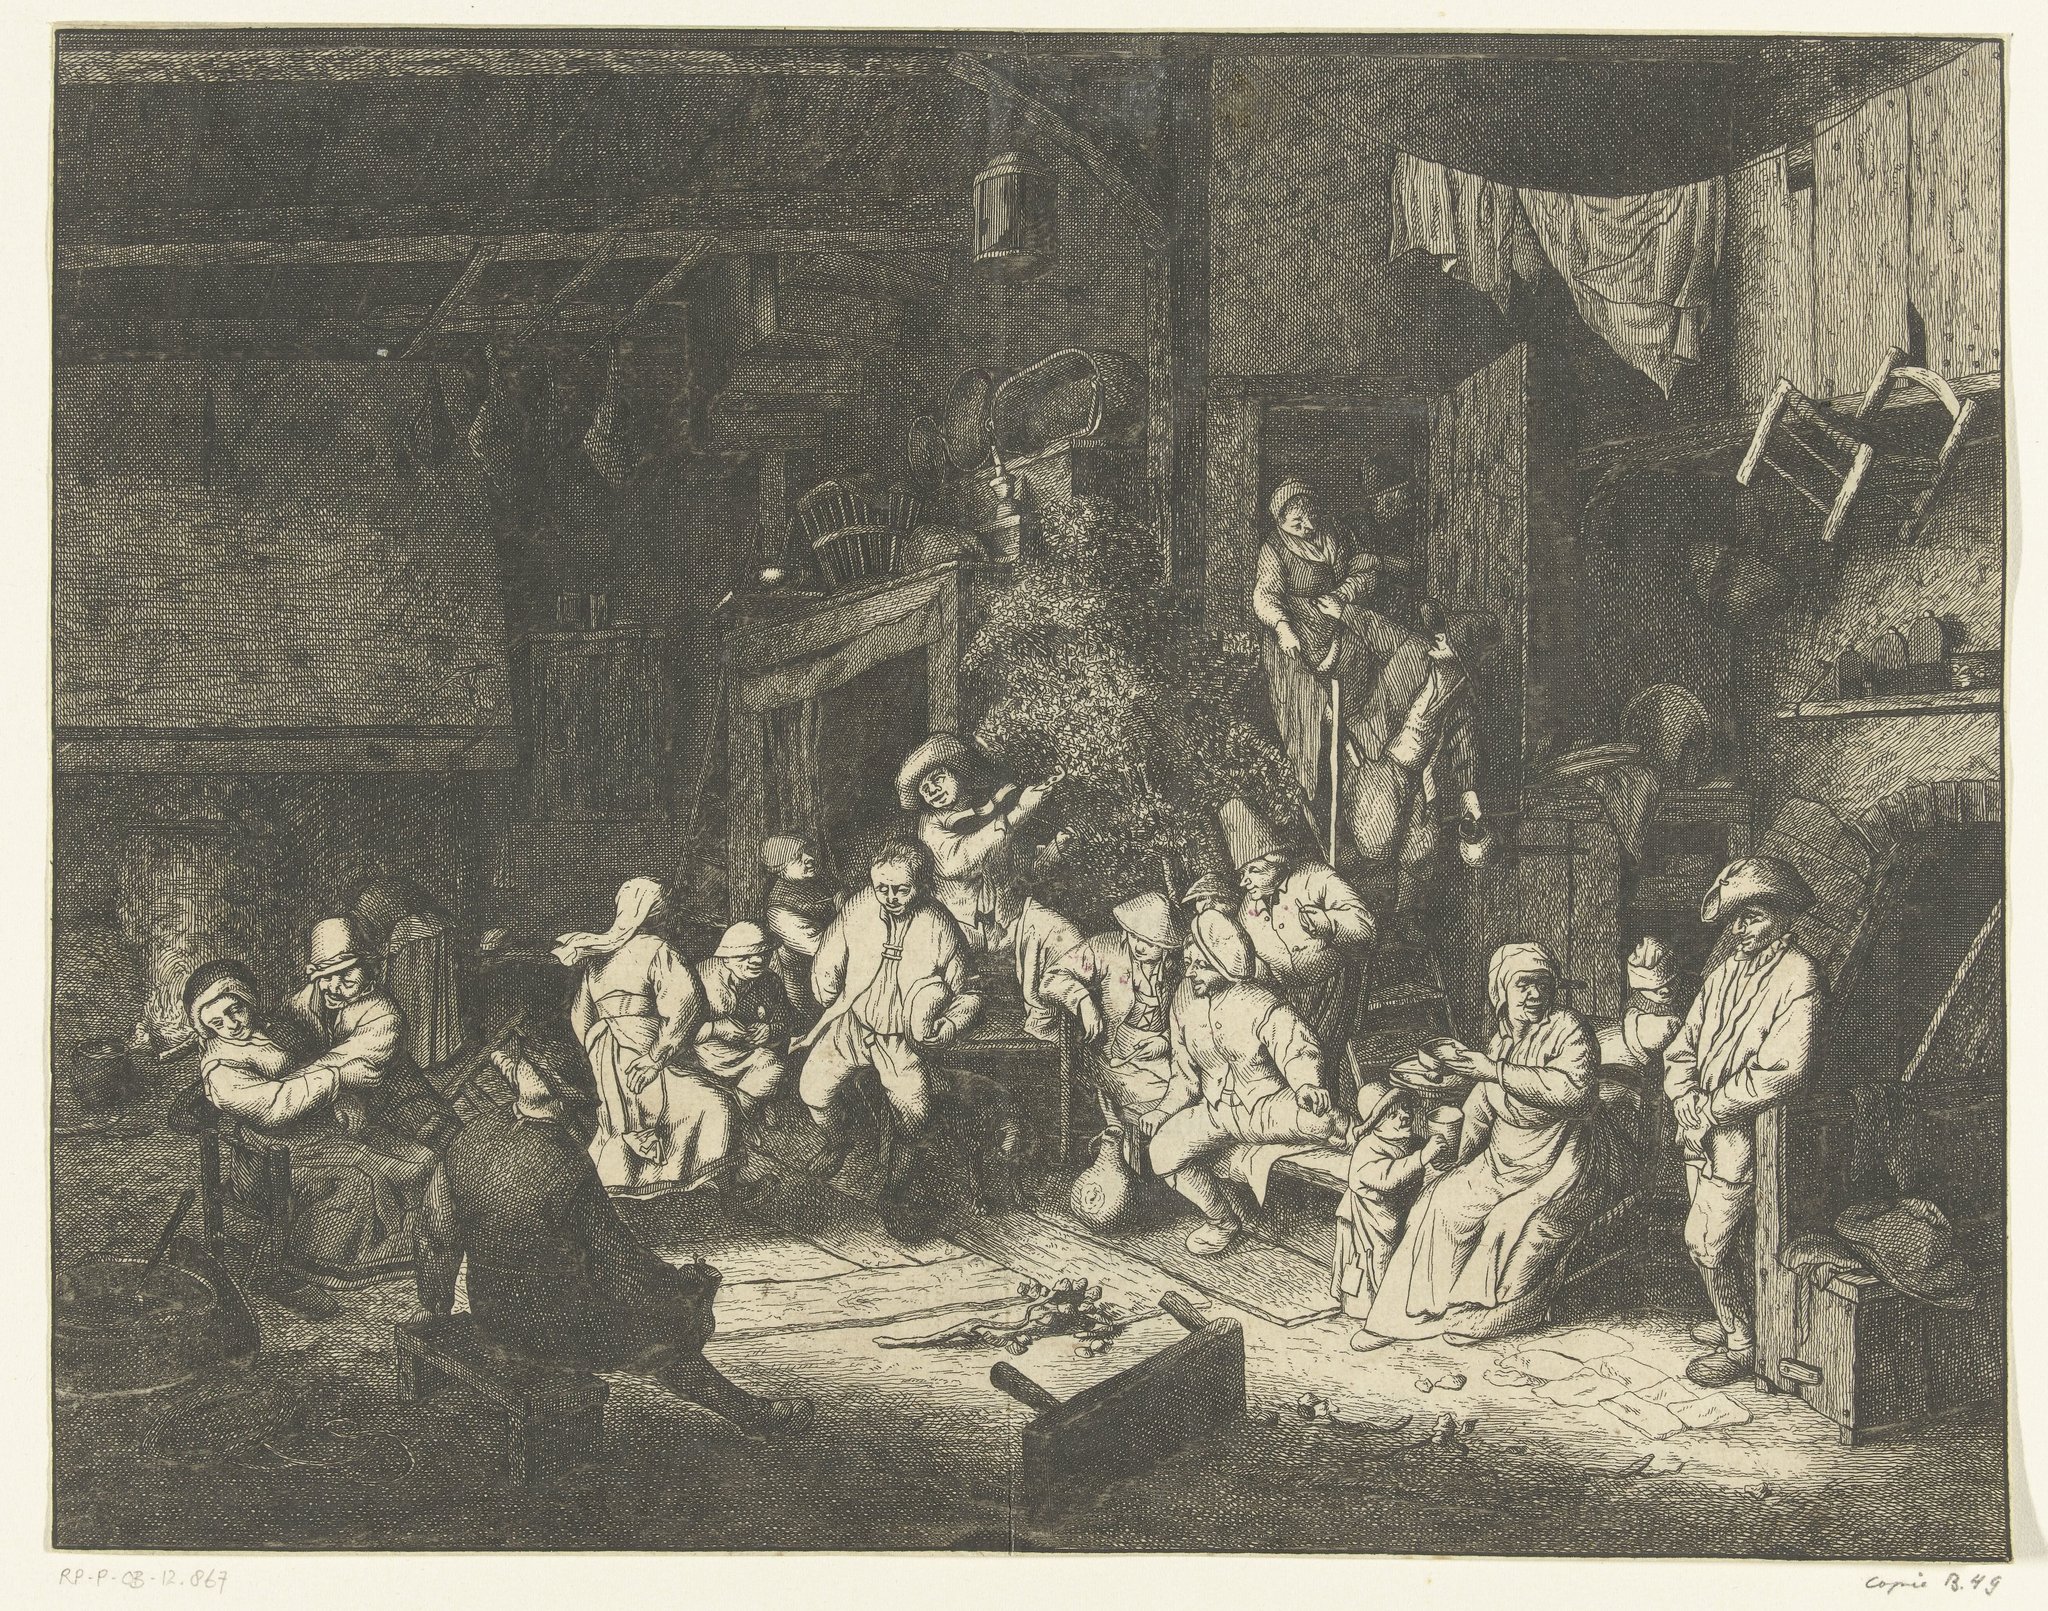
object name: print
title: Dans in de herberg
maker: Anonymous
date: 1650-1735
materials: paper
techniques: etching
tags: inn, coffee-house, public house, etc., one pair dancing; man and woman dancing as a couple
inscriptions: inscription: ‘Angl (...)’, collector's mark: Lugt 2228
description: Kopie in spiegelbeeld. Een groep mensen in een rommelige herberg, te midden van hen dansen een man en een vrouw op de muziek van een vedelspeler. Geheel links omhelst een man een zittende vrouw. Drie personen komen de herberg binnen via een trap.